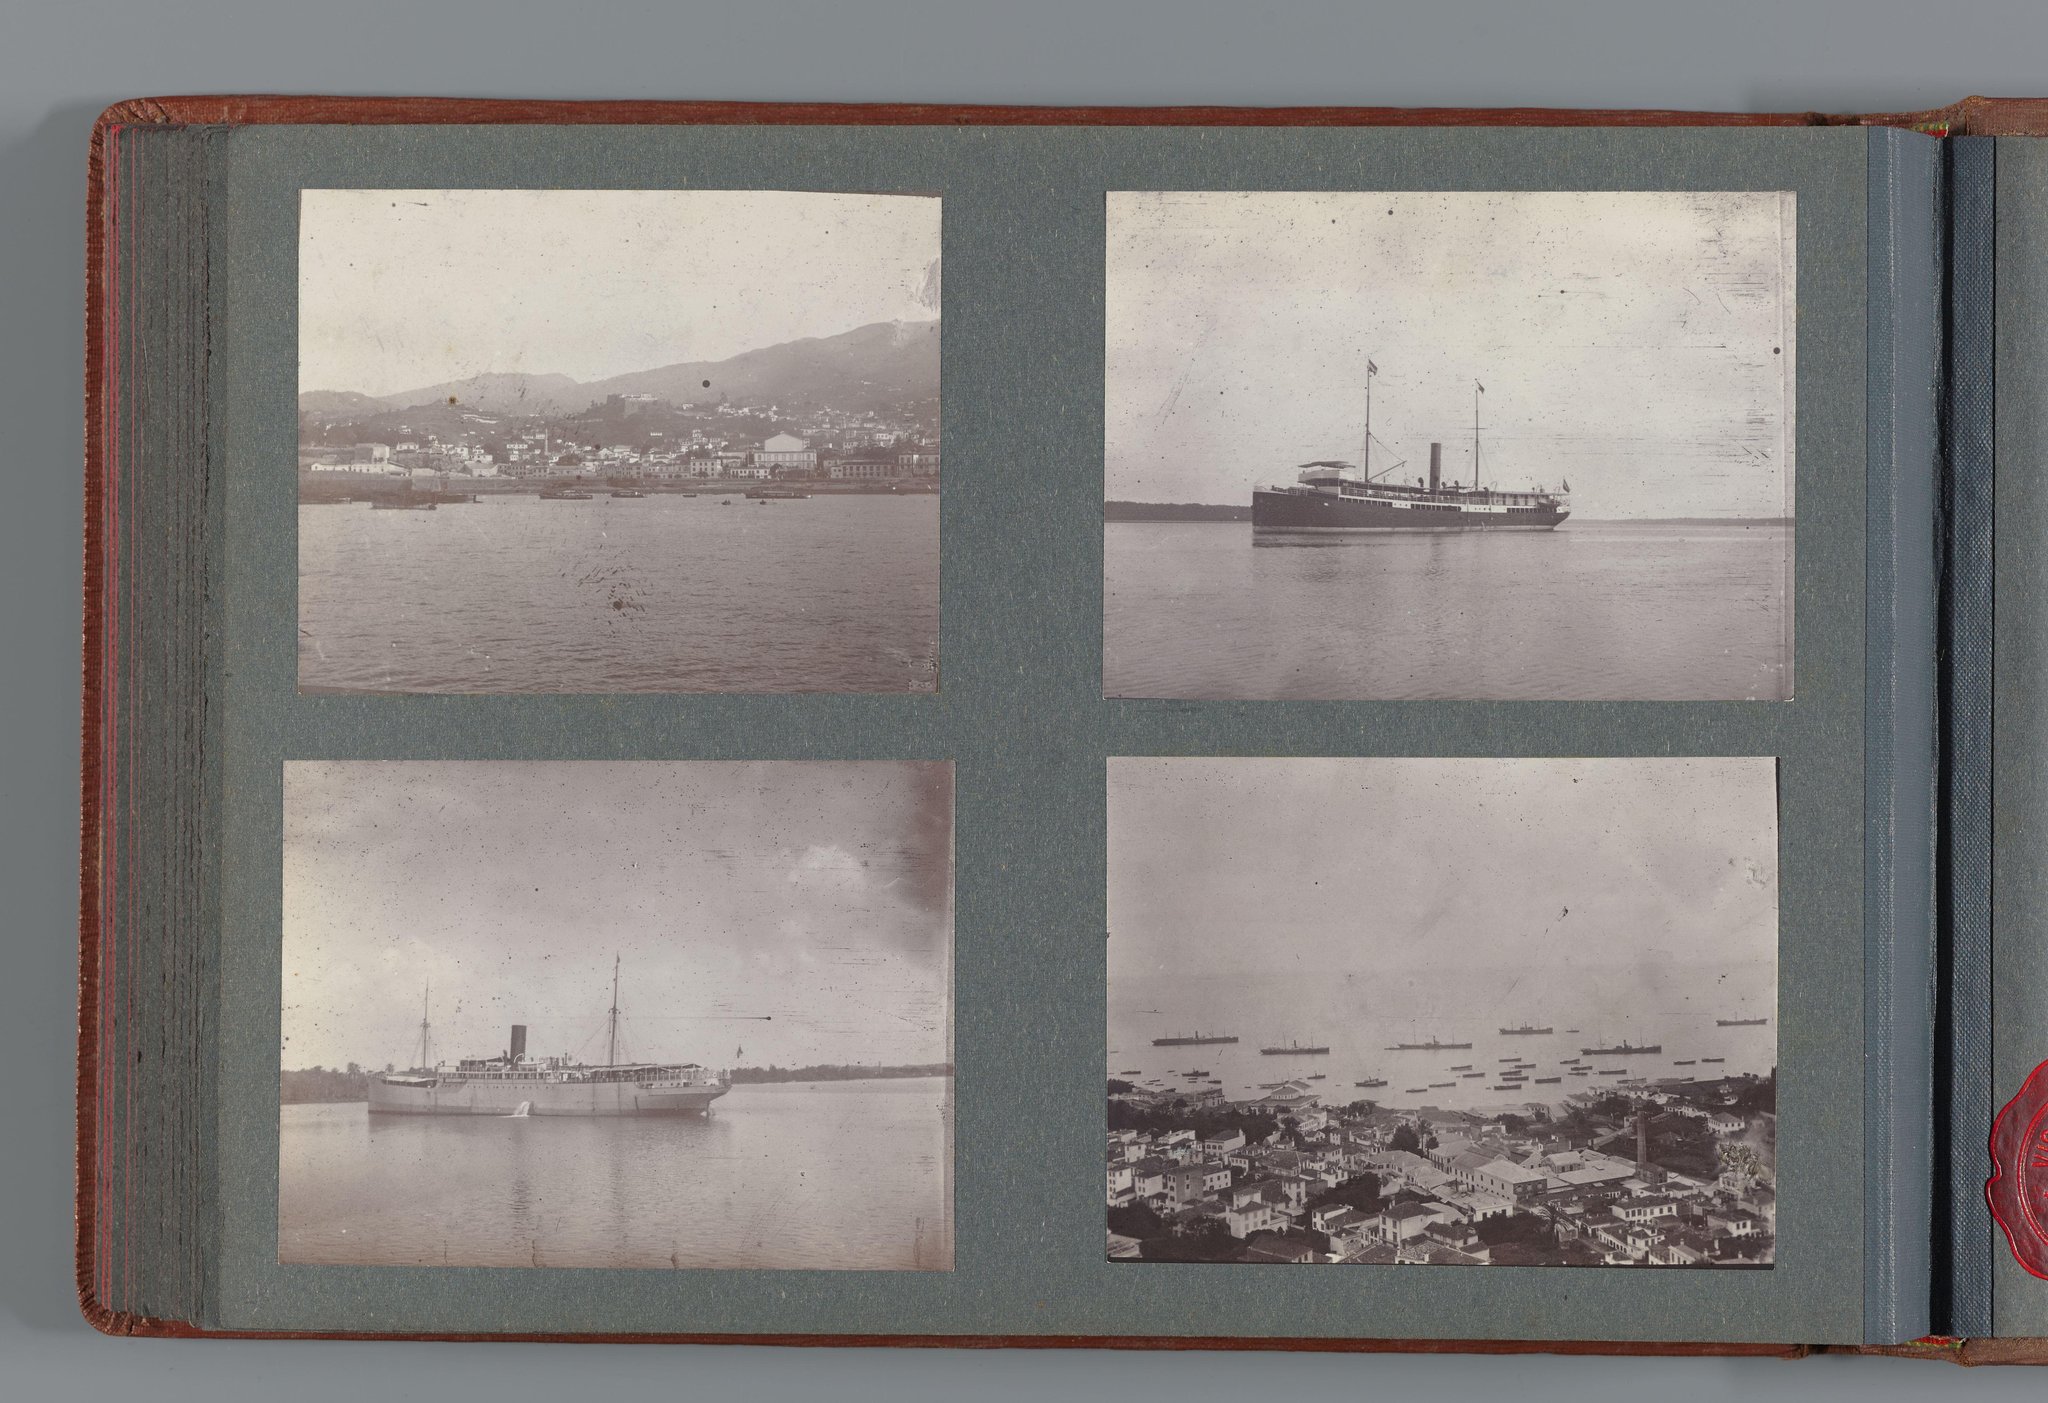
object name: photograph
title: Schepen voor de kust van Paramaribo (?)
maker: Anonymous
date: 1905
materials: cardboard, paper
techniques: photography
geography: paramaribo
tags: paramaribo (stad)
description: Schepen voor de kust van Paramaribo (?). Onderdeel van fotoalbum 'Suriname'.